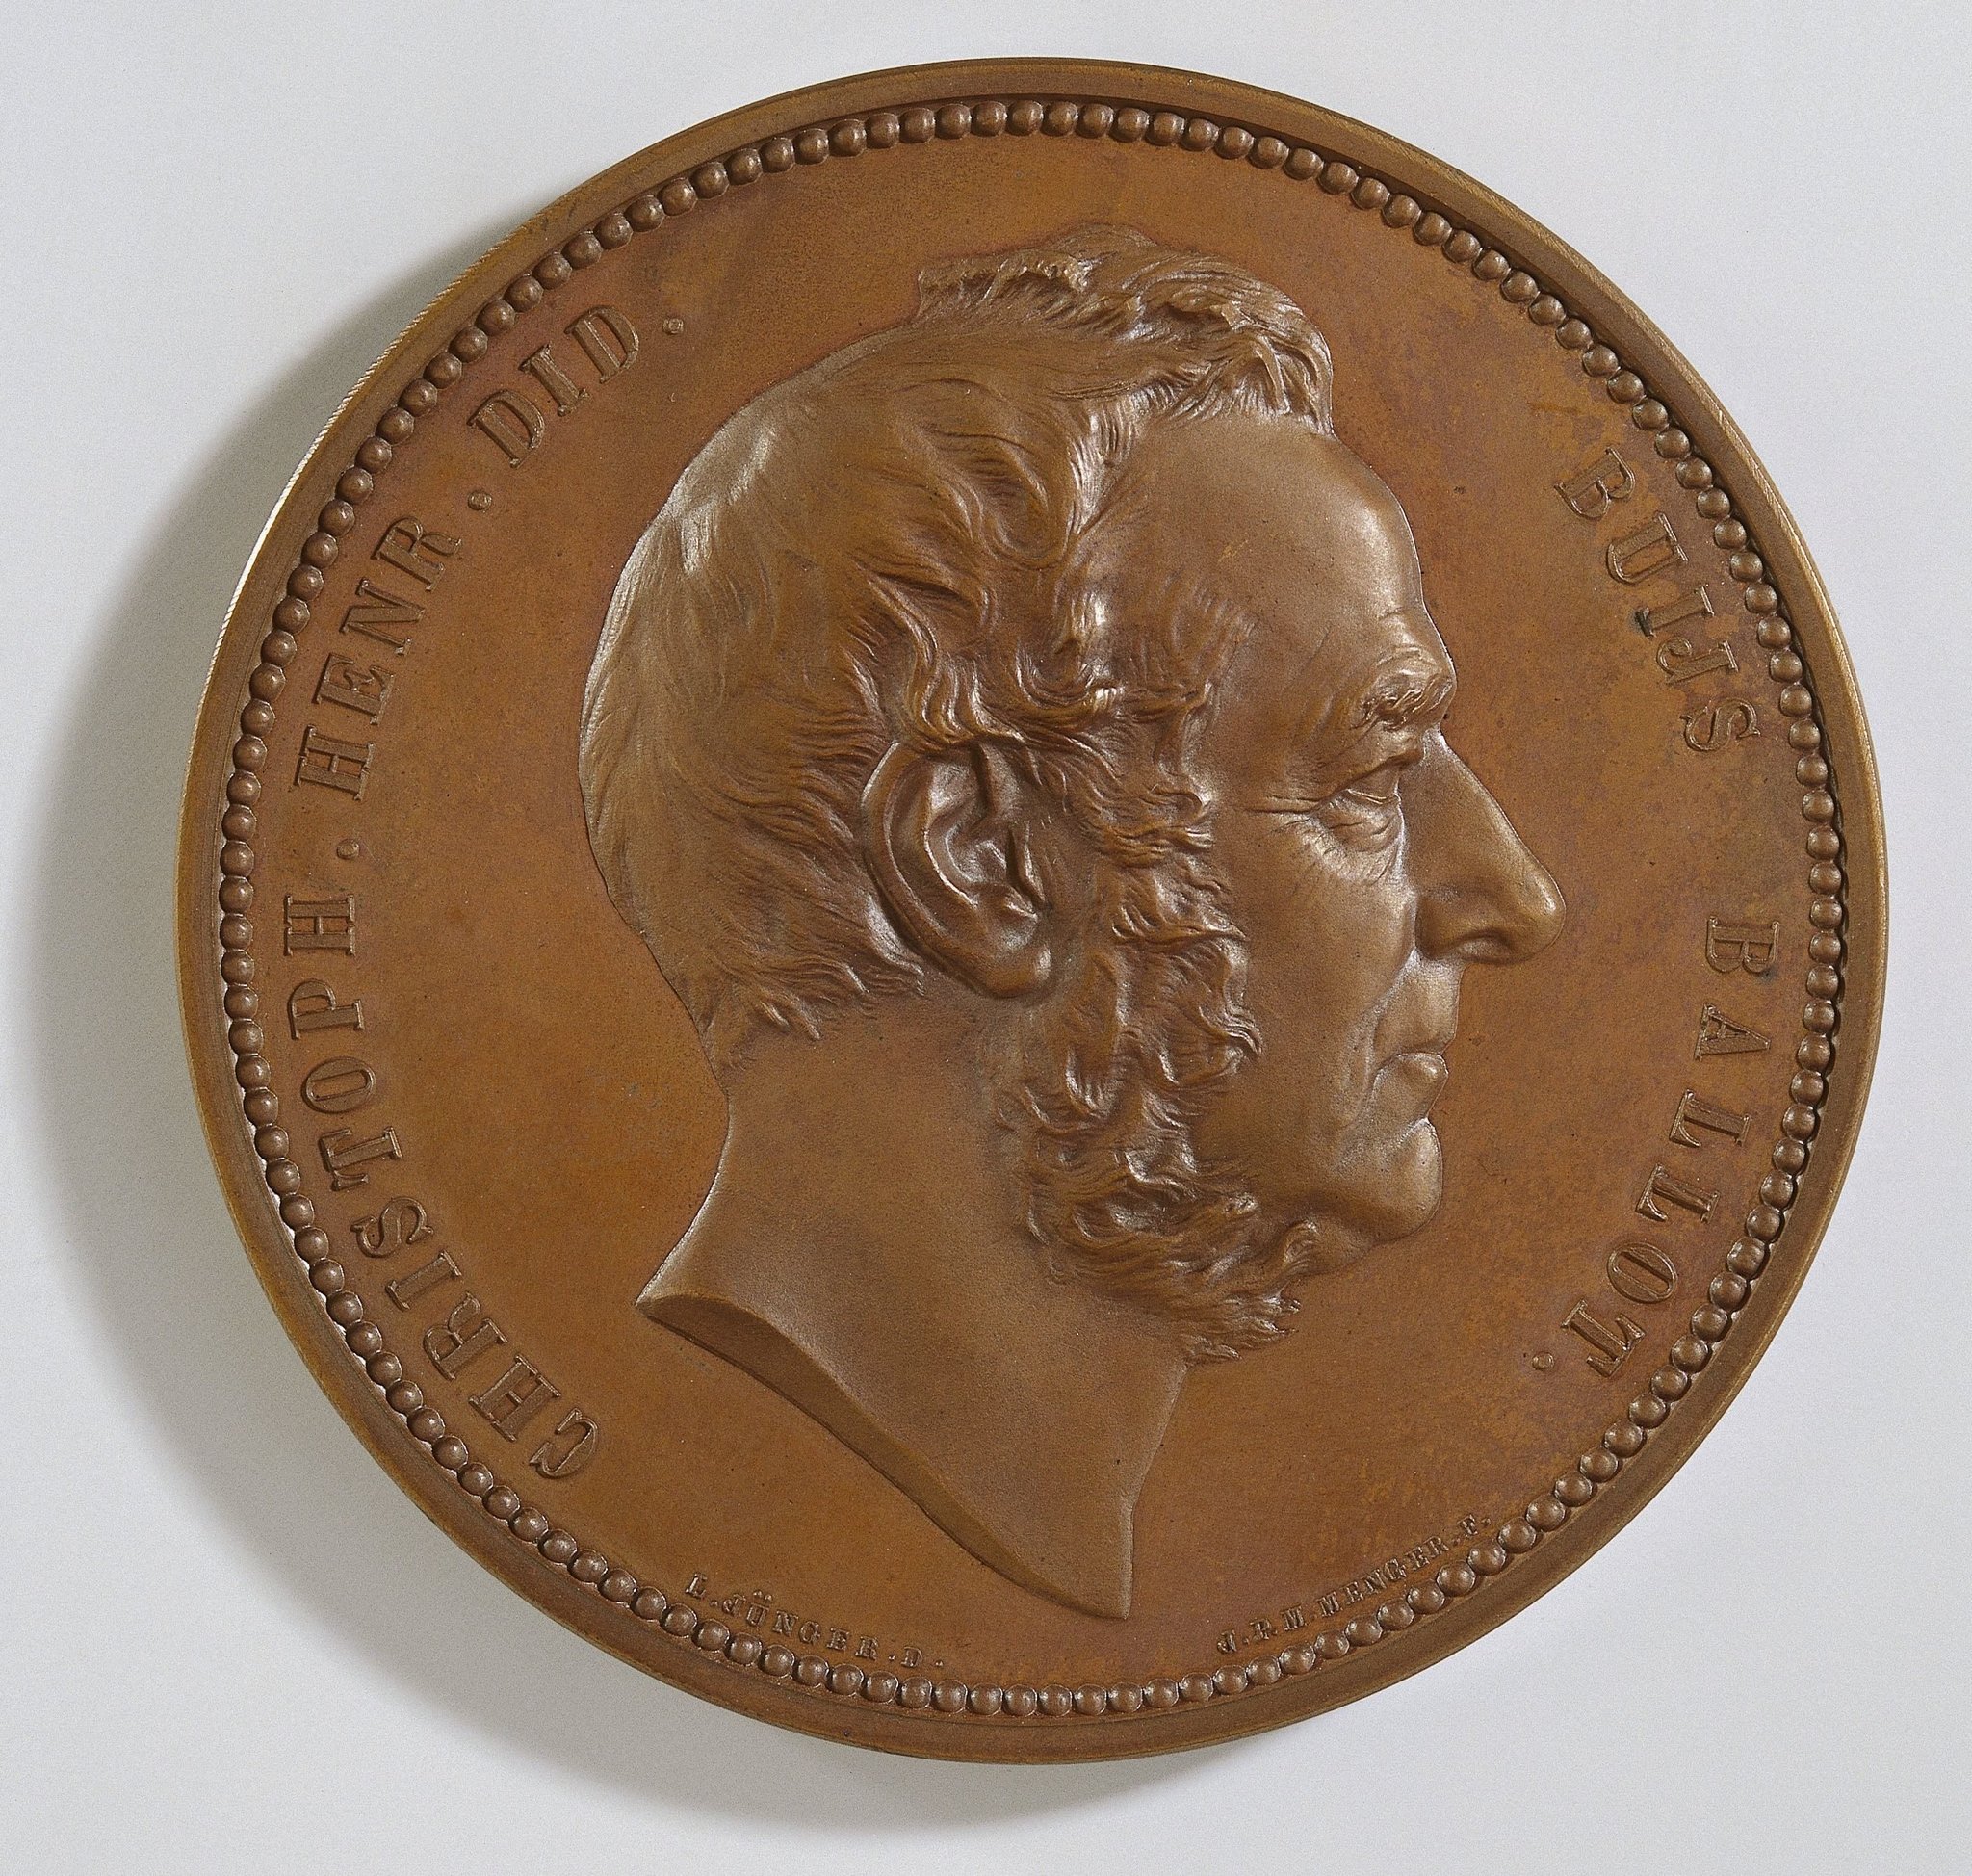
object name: honorary medal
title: Bronzen penning in doos van Christophorus Henricus Didericus Buys Ballot, veertig jaar hoogleraar aan de universiteit van Utrecht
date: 1887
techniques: striking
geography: netherlands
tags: utrecht, physicist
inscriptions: signature: ‘L. JÜNGER D.; J.P.M. MENGER F.’, signature: ‘W.S.’, inscription: ‘HULDE NA XL JAREN / VAN VRUCHTBARE / AKADEMISCHE / WERKZAAMHEID / XVI NOV. / MDCCCXLVII - MDCCCLXXXVII’, inscription: ‘CHRISTPH. HENDR. DID. BUIJS BALLOT’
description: Bronzen penning in doos. Voorzijde: borststuk man met profiel naar rechts binnen omschrift. Keerzijde: opschrift onder palm- en lauwertak binnen parelrand; op zijkant mercuriusstaf.